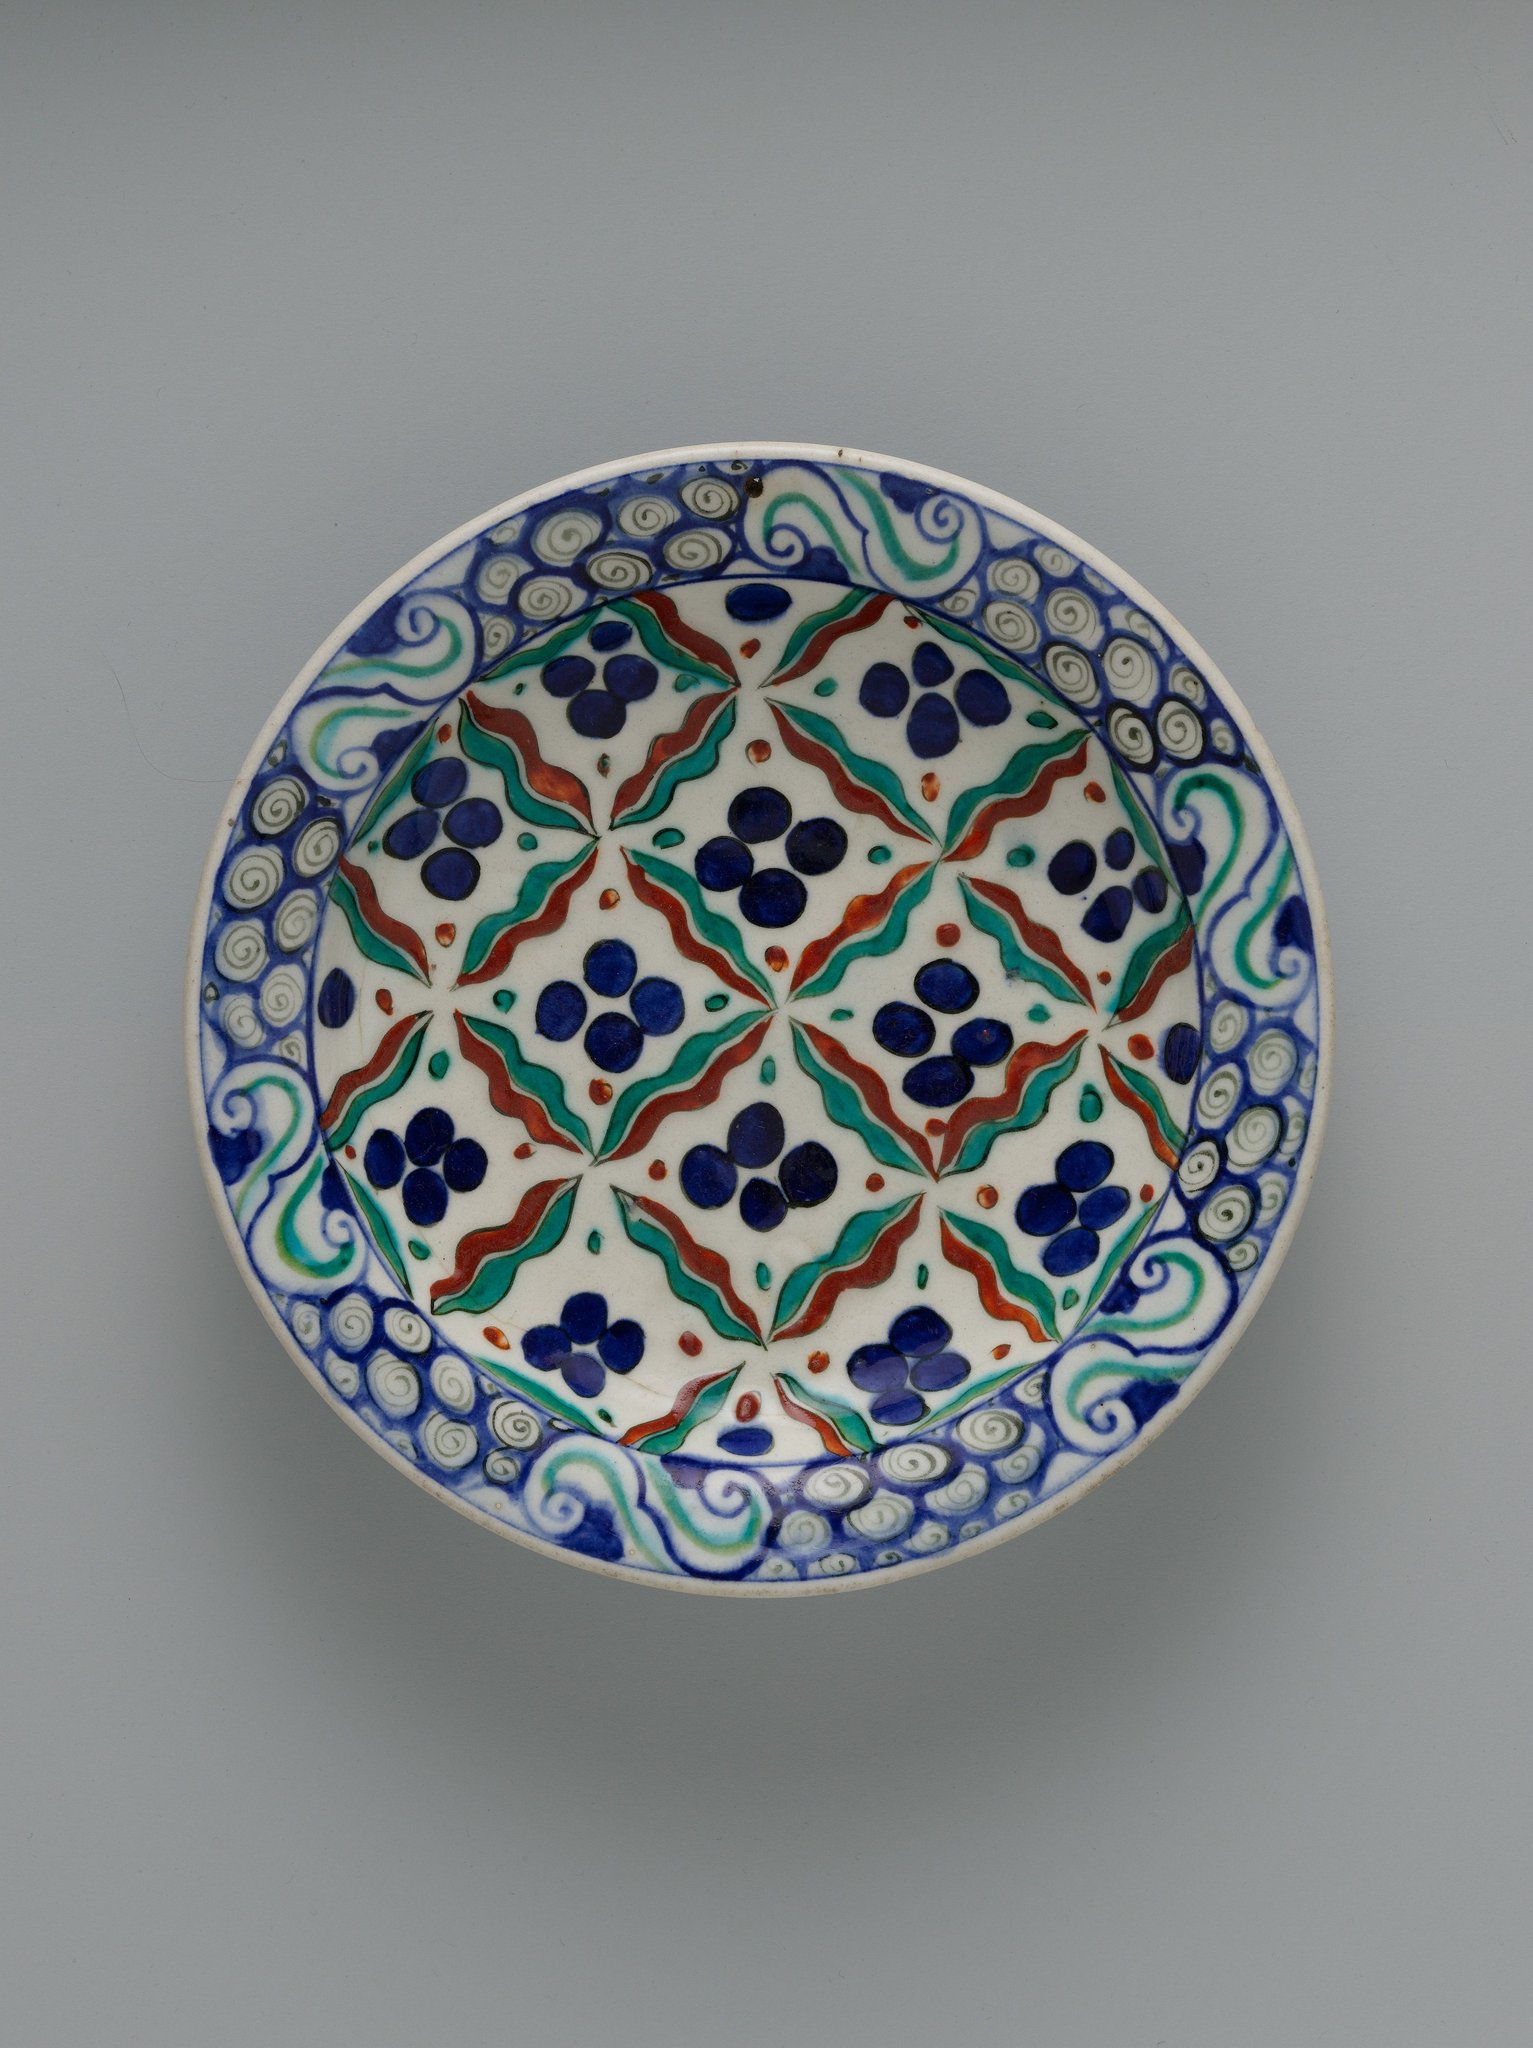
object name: dish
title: Dish with 'Cintamani' and Tiger-stripe Pattern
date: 1575-1590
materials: glaze, stonepaste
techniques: painting, polychrome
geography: turkey